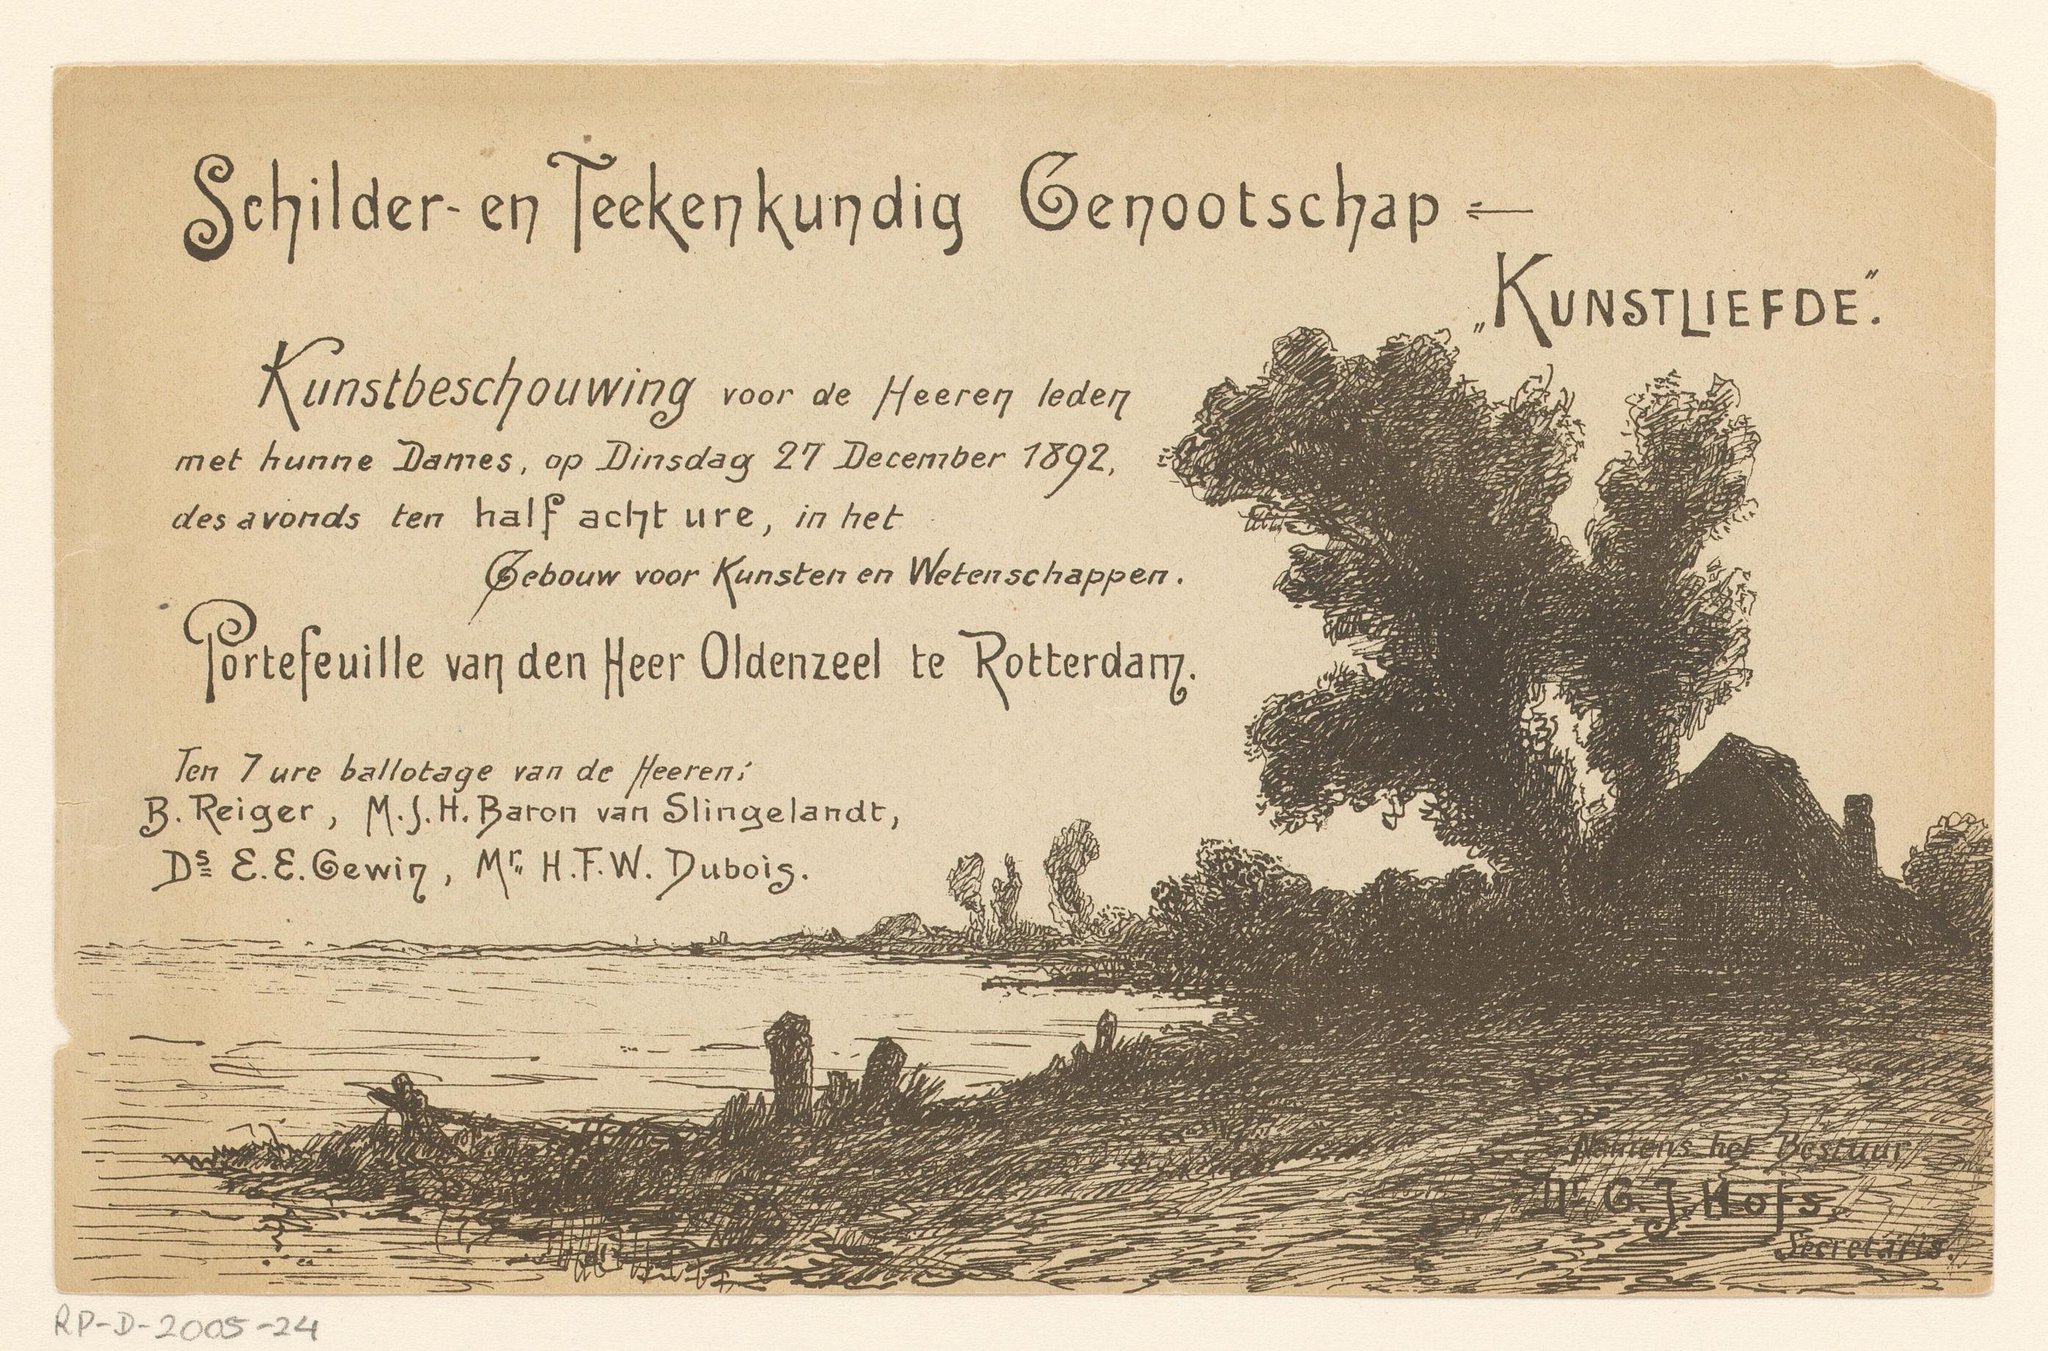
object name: print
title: Uitnodiging van Schilder- en Teekenkundig Genootschap "Kunstliefde" voor een kunstbeschouwing, 27 december 1892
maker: Anonymous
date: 1812-1892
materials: paper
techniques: lithograph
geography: utrecht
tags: criticizing and discussing art, art criticism, circle, club of artists, collecting and exhibiting products of the fine arts, river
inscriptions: collector's mark: Lugt 2228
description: Landschap met huis onder bomen aan de waterkant. Uitnodiging van Schilder- en Teekenkundig Genootschap "Kunstliefde" voor een kunstbeschouwing op 27 december 1892 van de portefeuille van dhr. Oldenzeel te Rotterdam. In het Gebouw voor Kunsten en Wetenschappen te Utrecht.